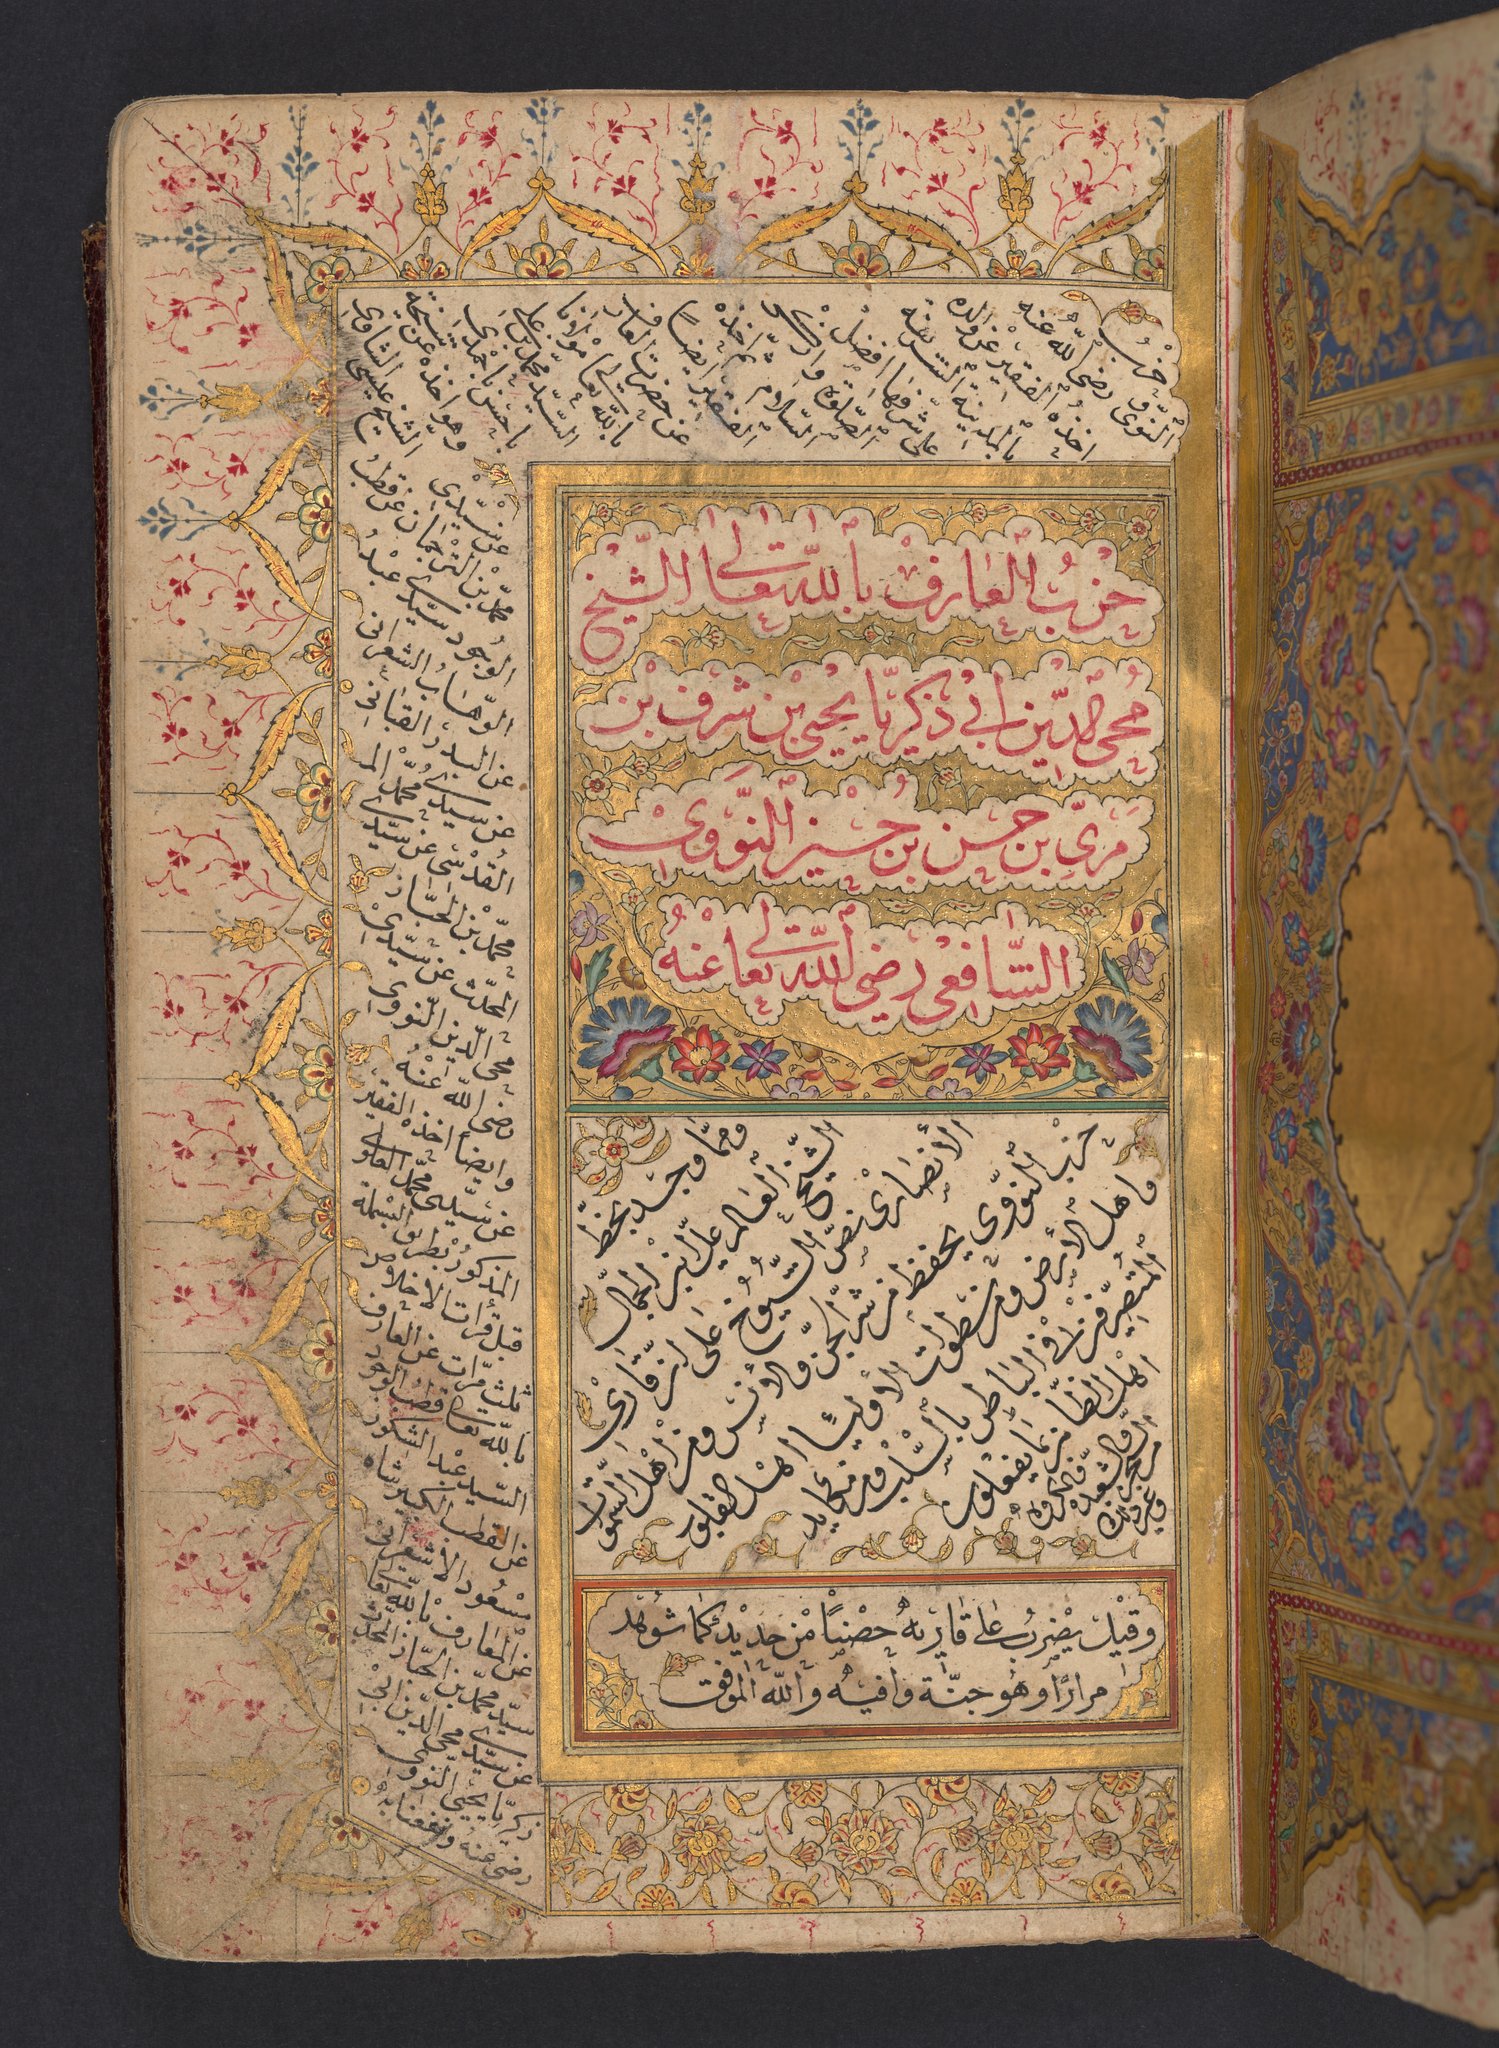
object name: non illustrated manuscript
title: Hizb (Litany) of An-Nawawi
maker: an-nawawi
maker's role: author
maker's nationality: syrian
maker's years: 1233-1277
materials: gold, ink, paper, watercolor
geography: turkey